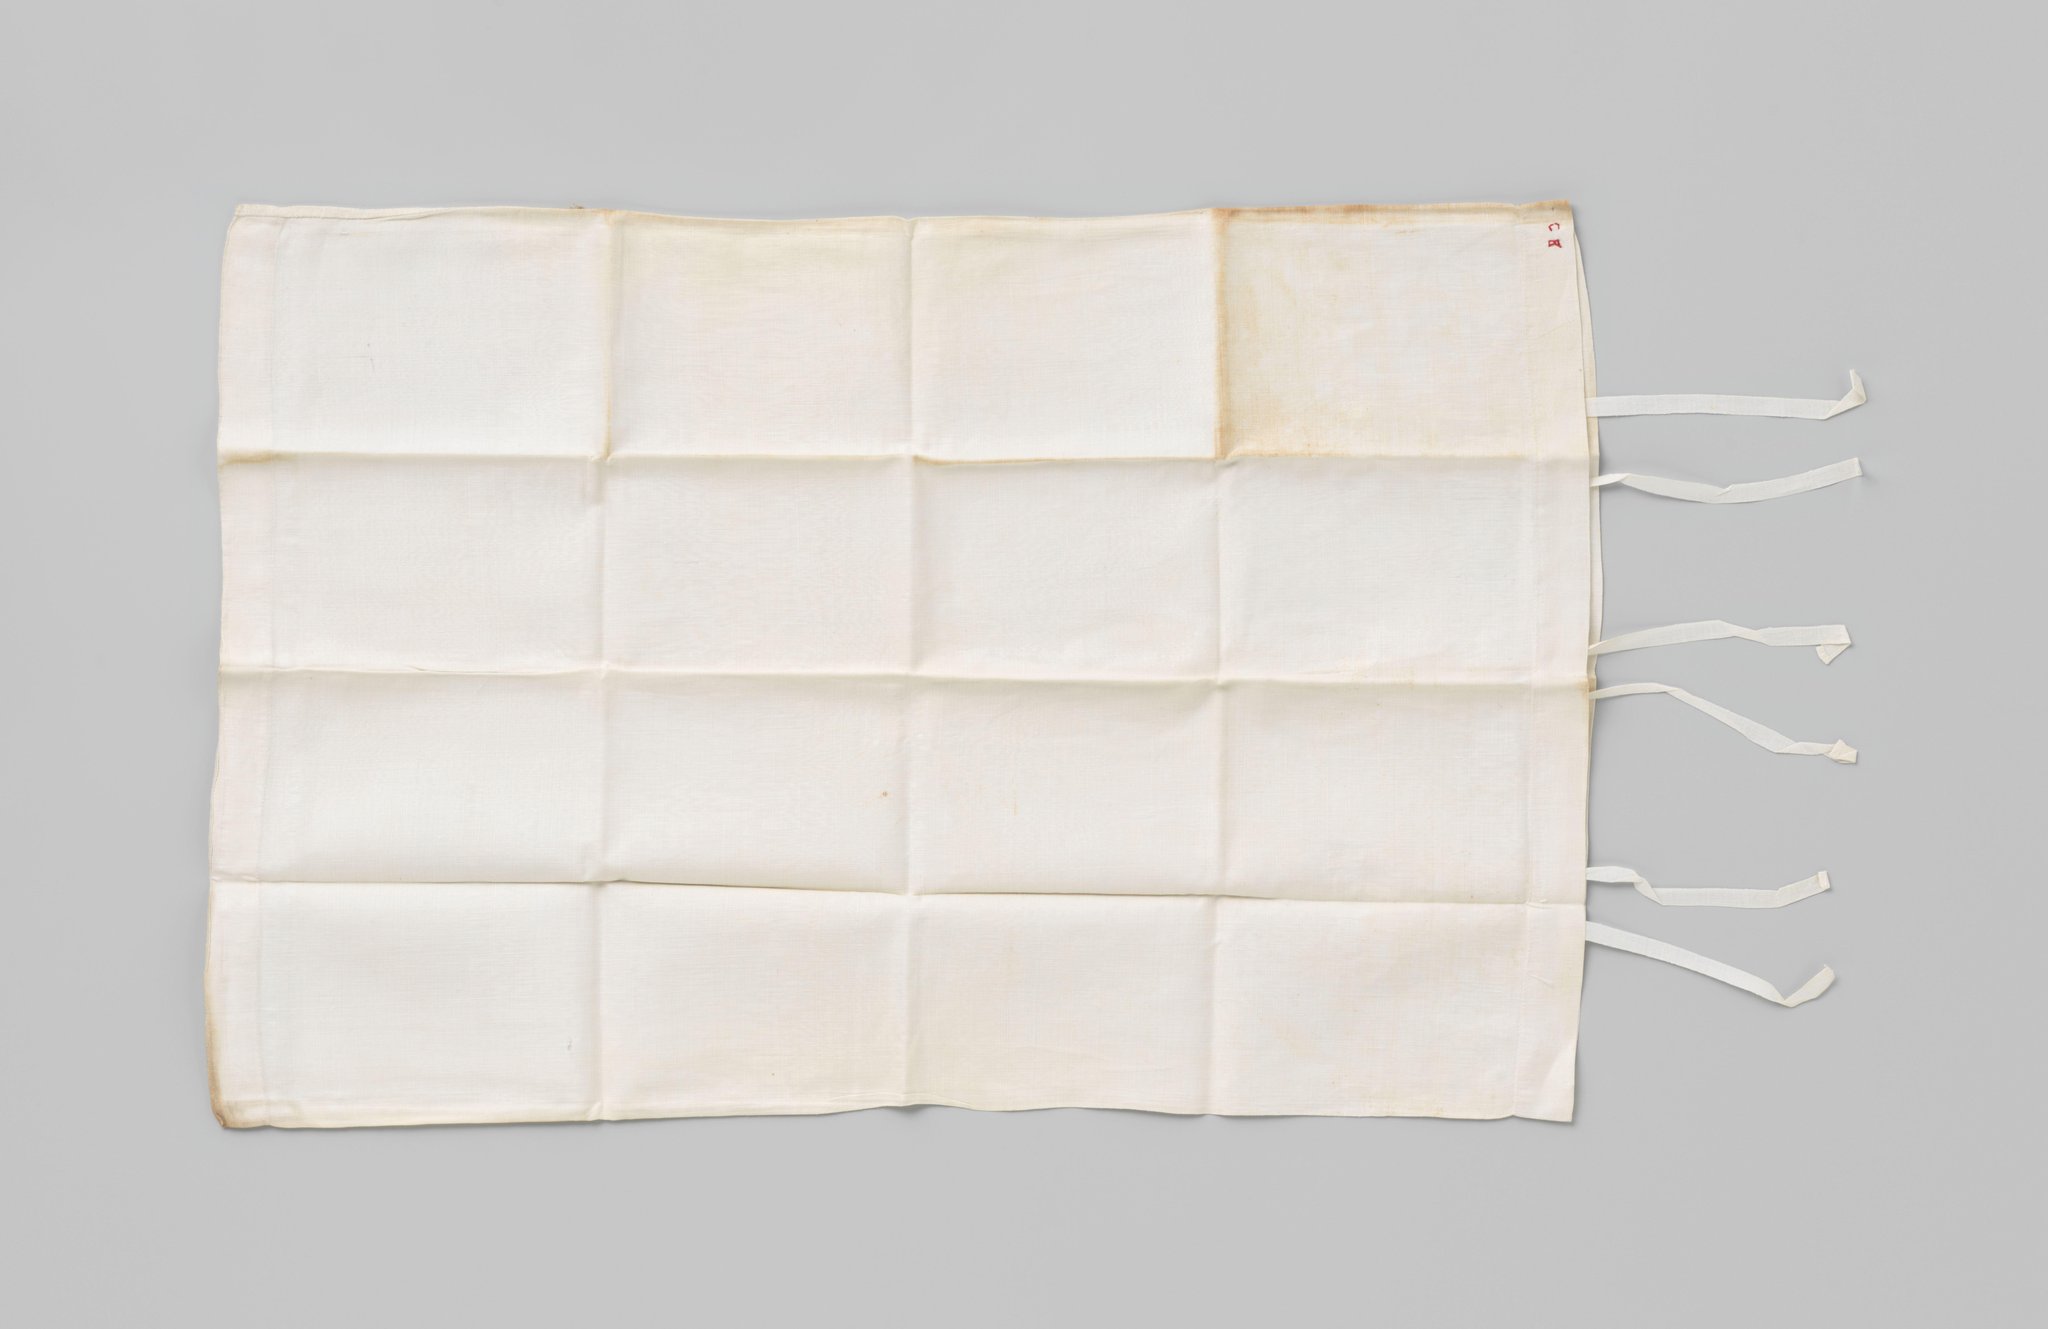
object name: lendensloop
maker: Anonymous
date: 1880-1934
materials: linen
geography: northern netherlands